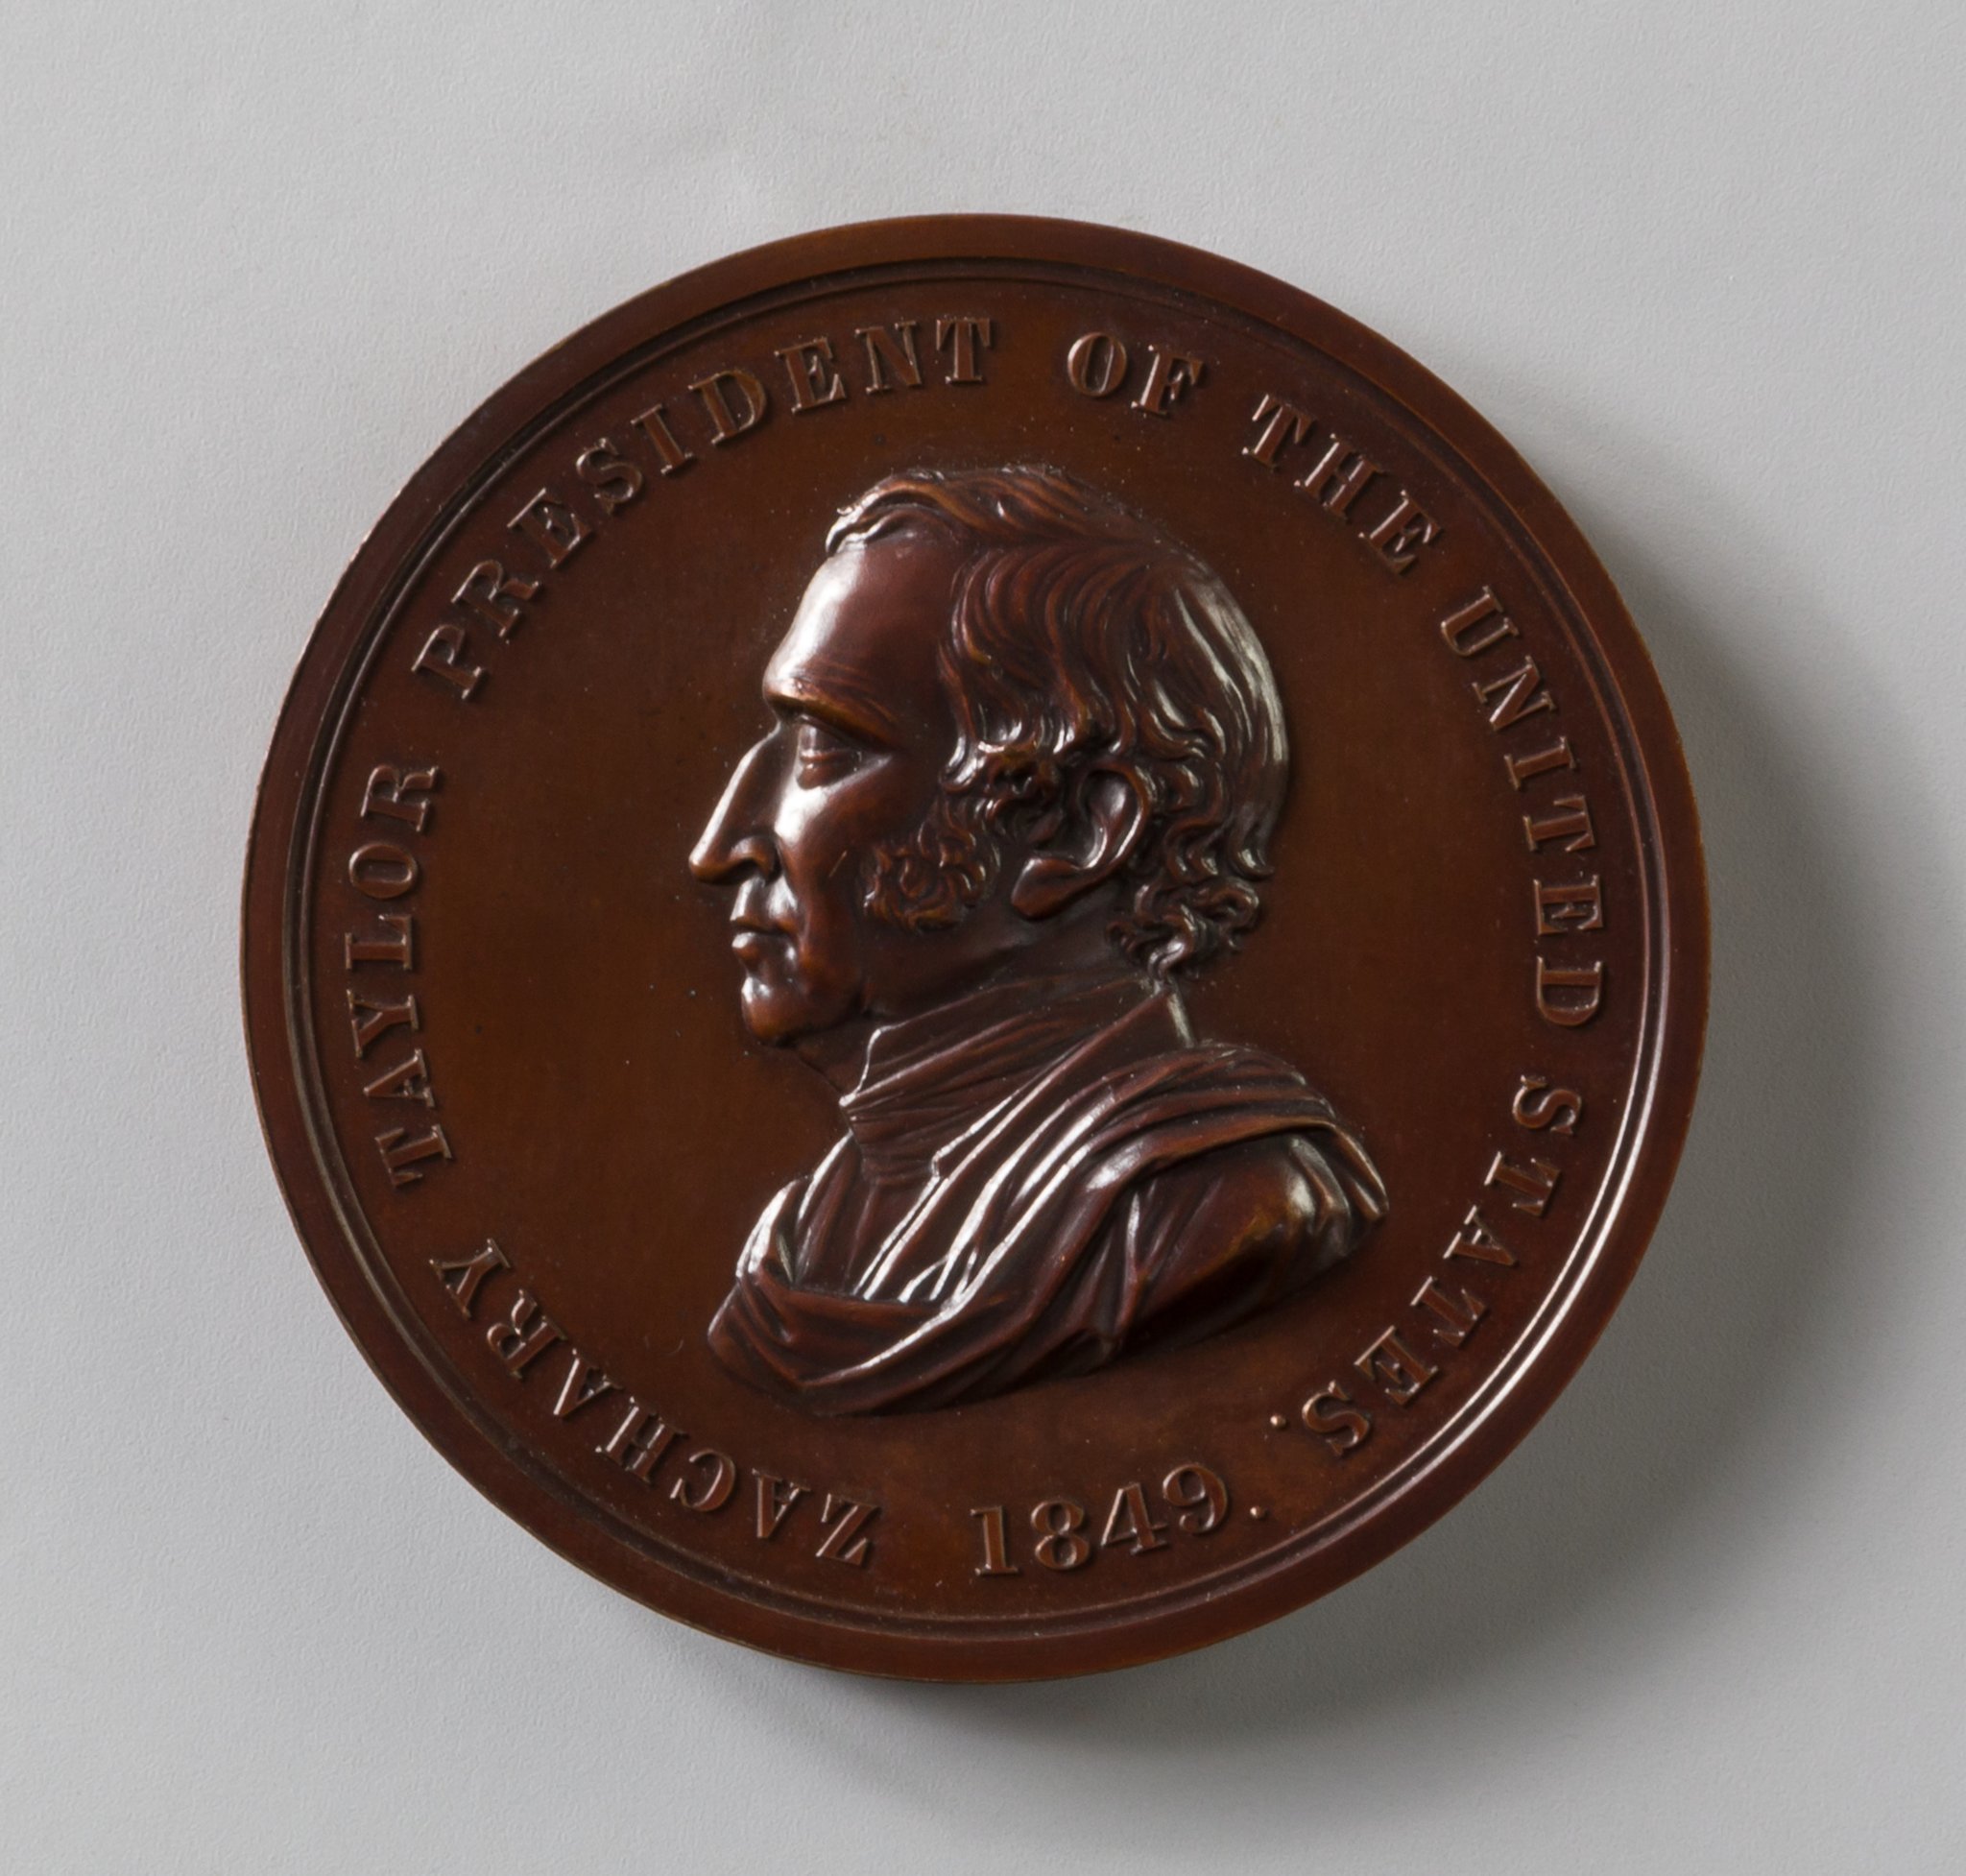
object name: medal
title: Medal of Zachary Taylor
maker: franklin peale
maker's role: maker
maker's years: 1795-1870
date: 1849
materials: bronze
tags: men,profiles